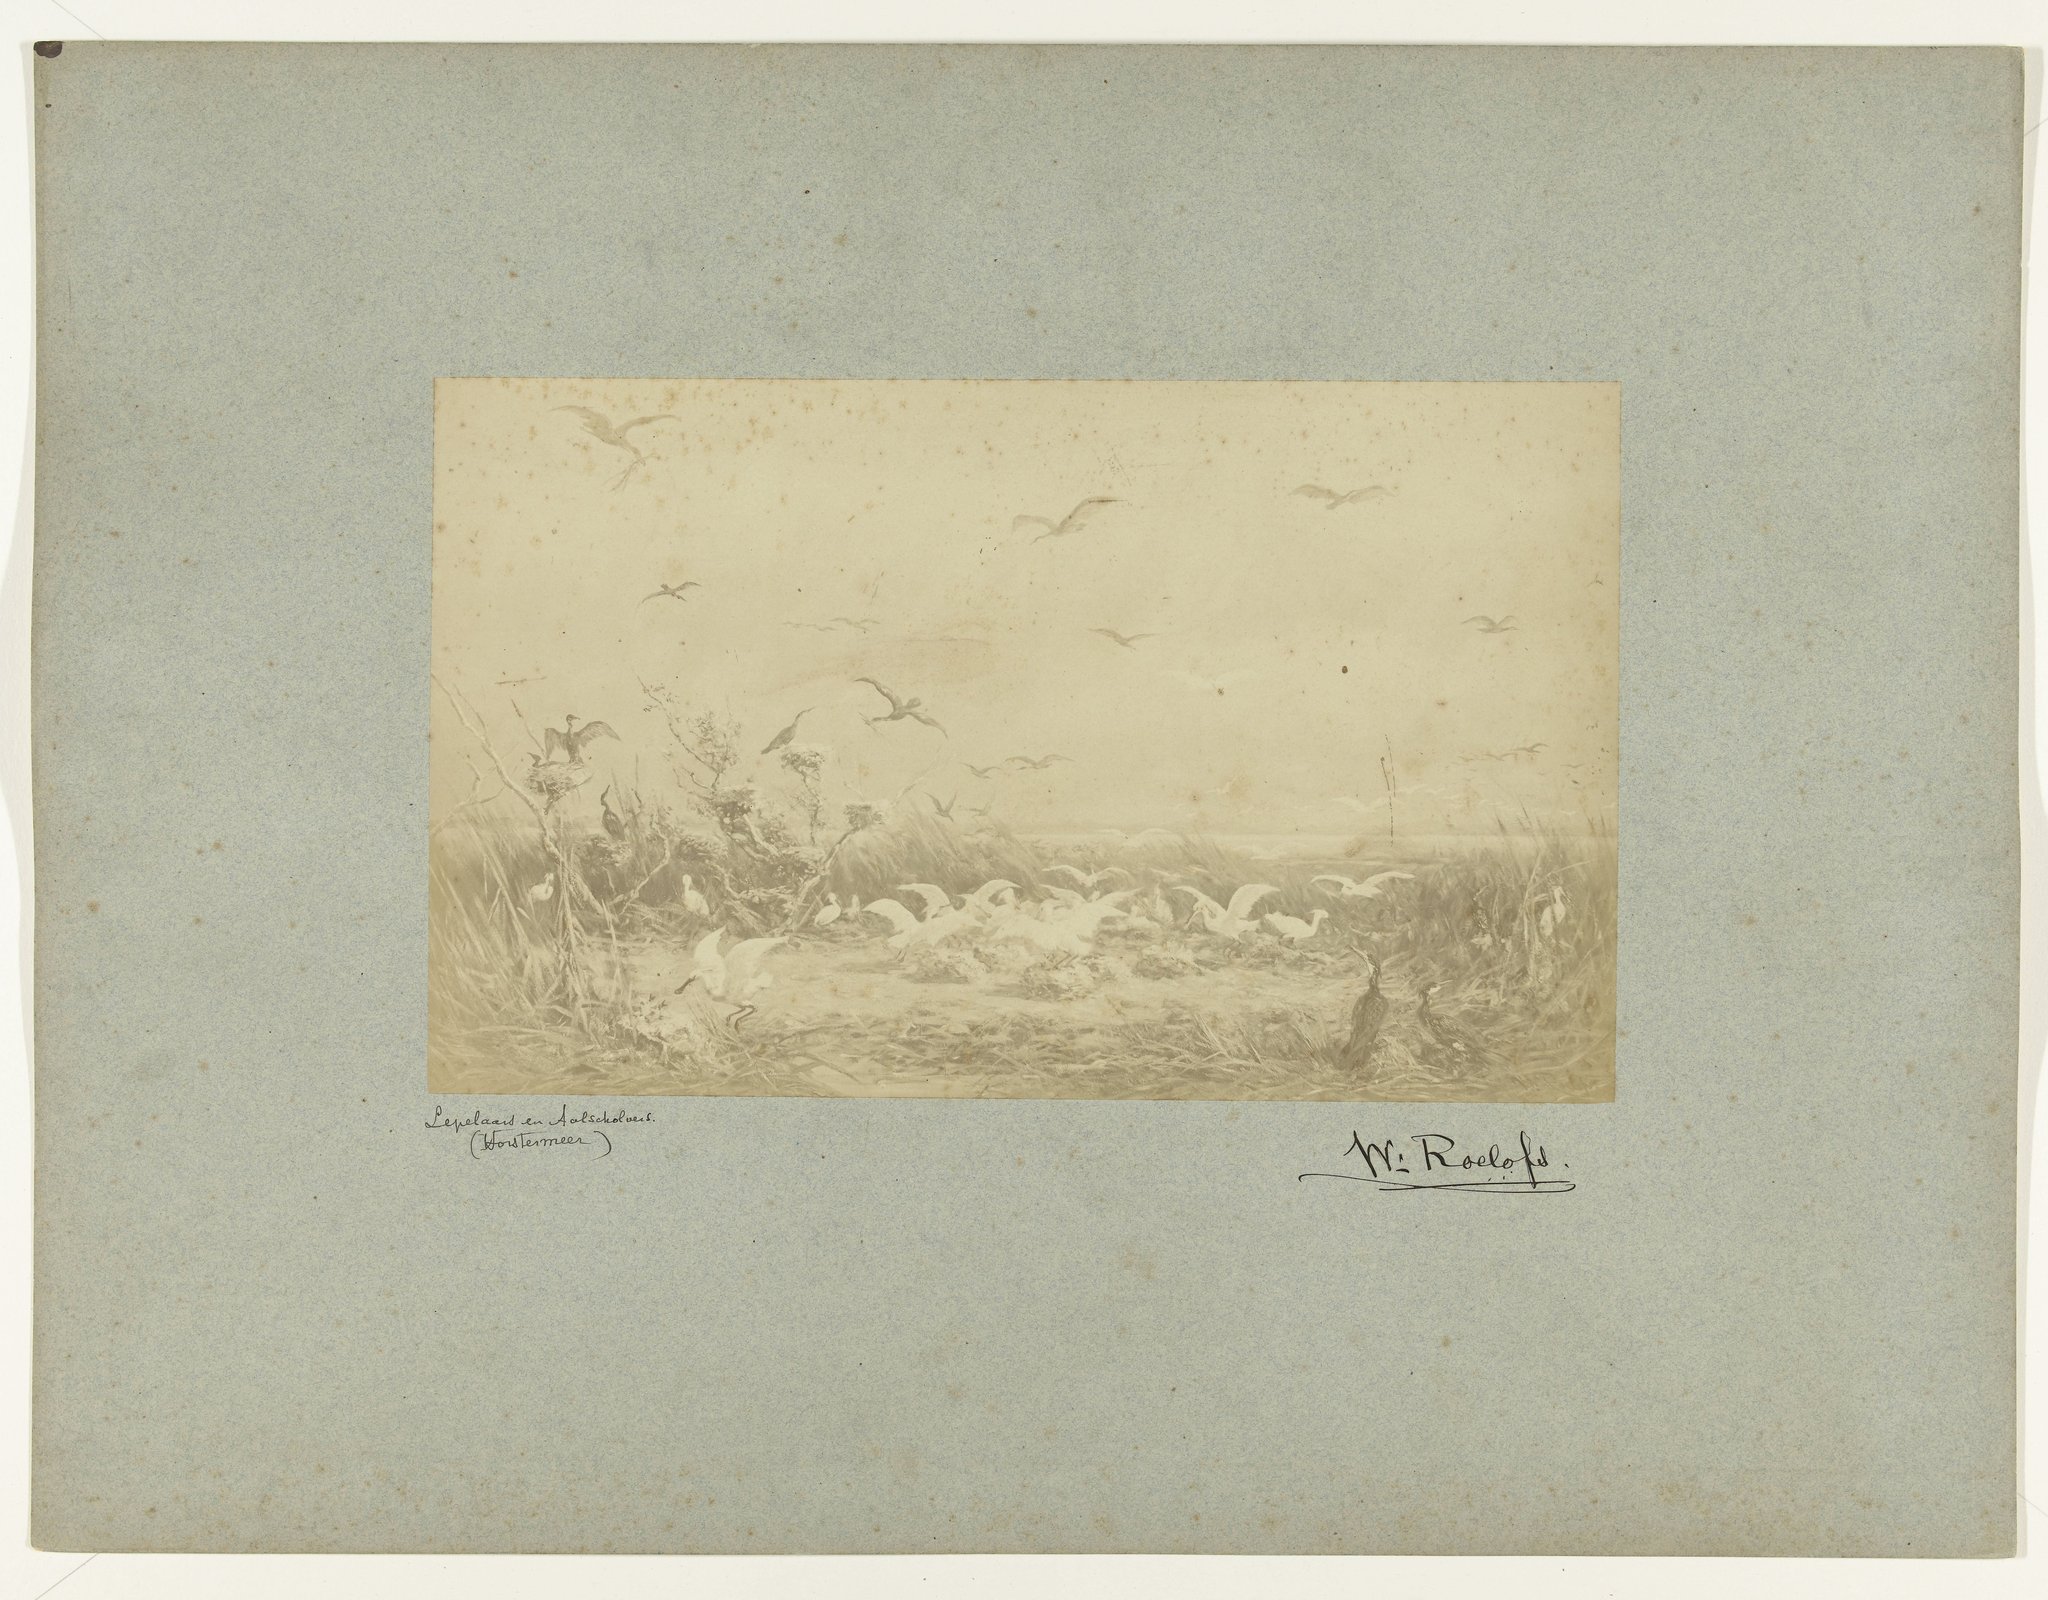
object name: photograph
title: Fotoreproductie van schilderij Lepelaars en Aalscholvers bij het Horstermeer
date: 1875-1890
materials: cardboard, photographic support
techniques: albumen print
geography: netherlands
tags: picture, painting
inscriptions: caption: ‘Lepelaars en Aalscholvers/ (Horstermeer)’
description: Foto-reproductie van schilderij Lepelaars en Aalscholvers bij het Horstermeer van Willem Roelofs.